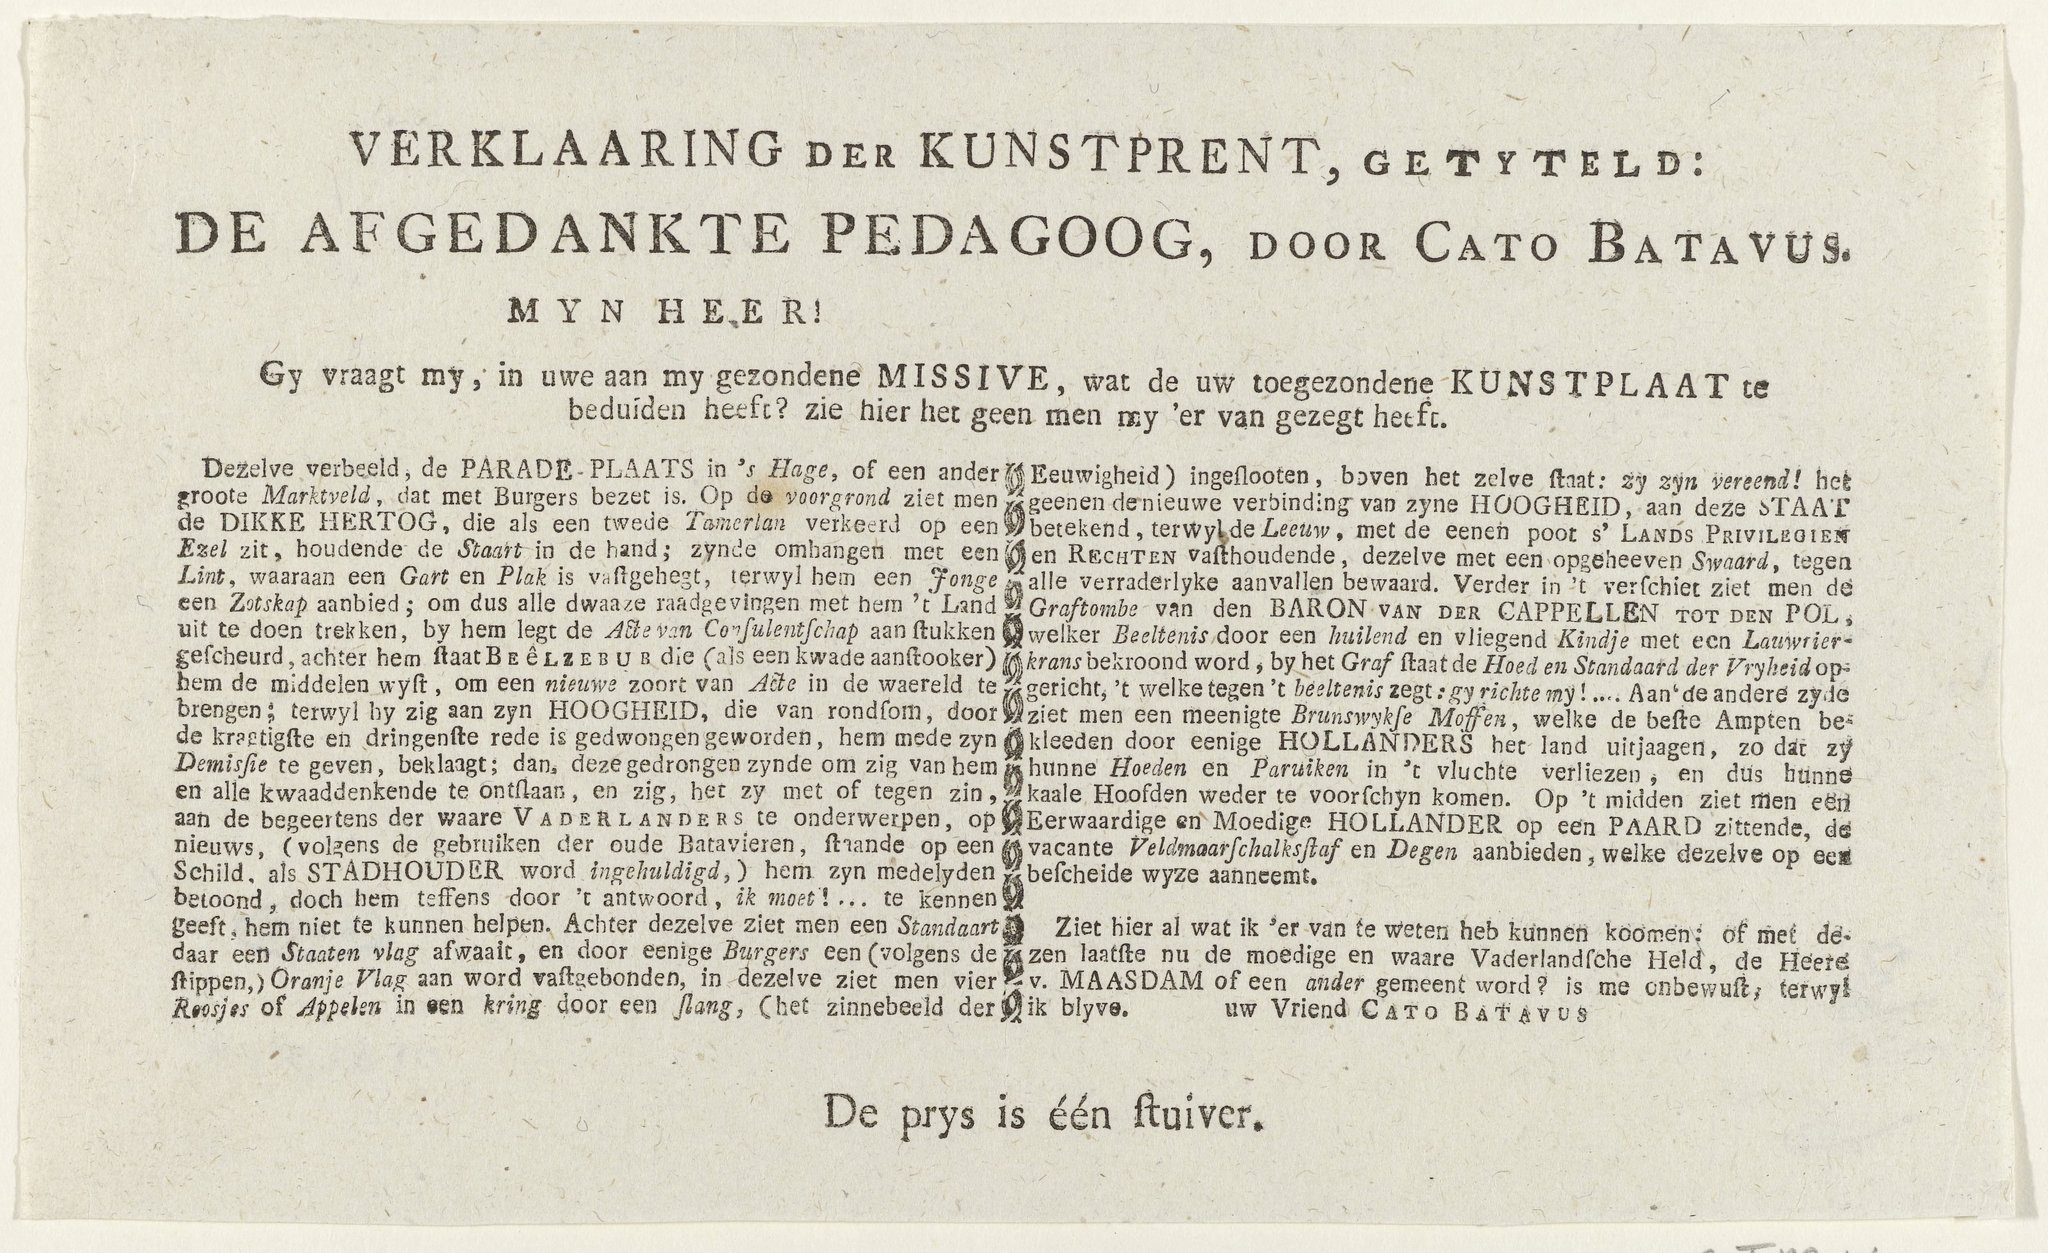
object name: cartoon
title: Verklaring van de spotprent op het vertrek van de hertog van Brunswijk uit Nederland, 1784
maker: Anonymous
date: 1784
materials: paper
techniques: letterpress printing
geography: northern netherlands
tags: william v (prince of orange), ludwig ernst von braunschweig-wolfenbüttel, the hague, patriots (1780-1795)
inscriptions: collector's mark: Lugt 2228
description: Tekstblad met een verklaring door Cato Batavus van de voorstelling van de spotprent op het vertrek van de hertog van Brunswijk uit Nederland, 14 oktober 1784. Onder vermeld: De prys is één stuiver.